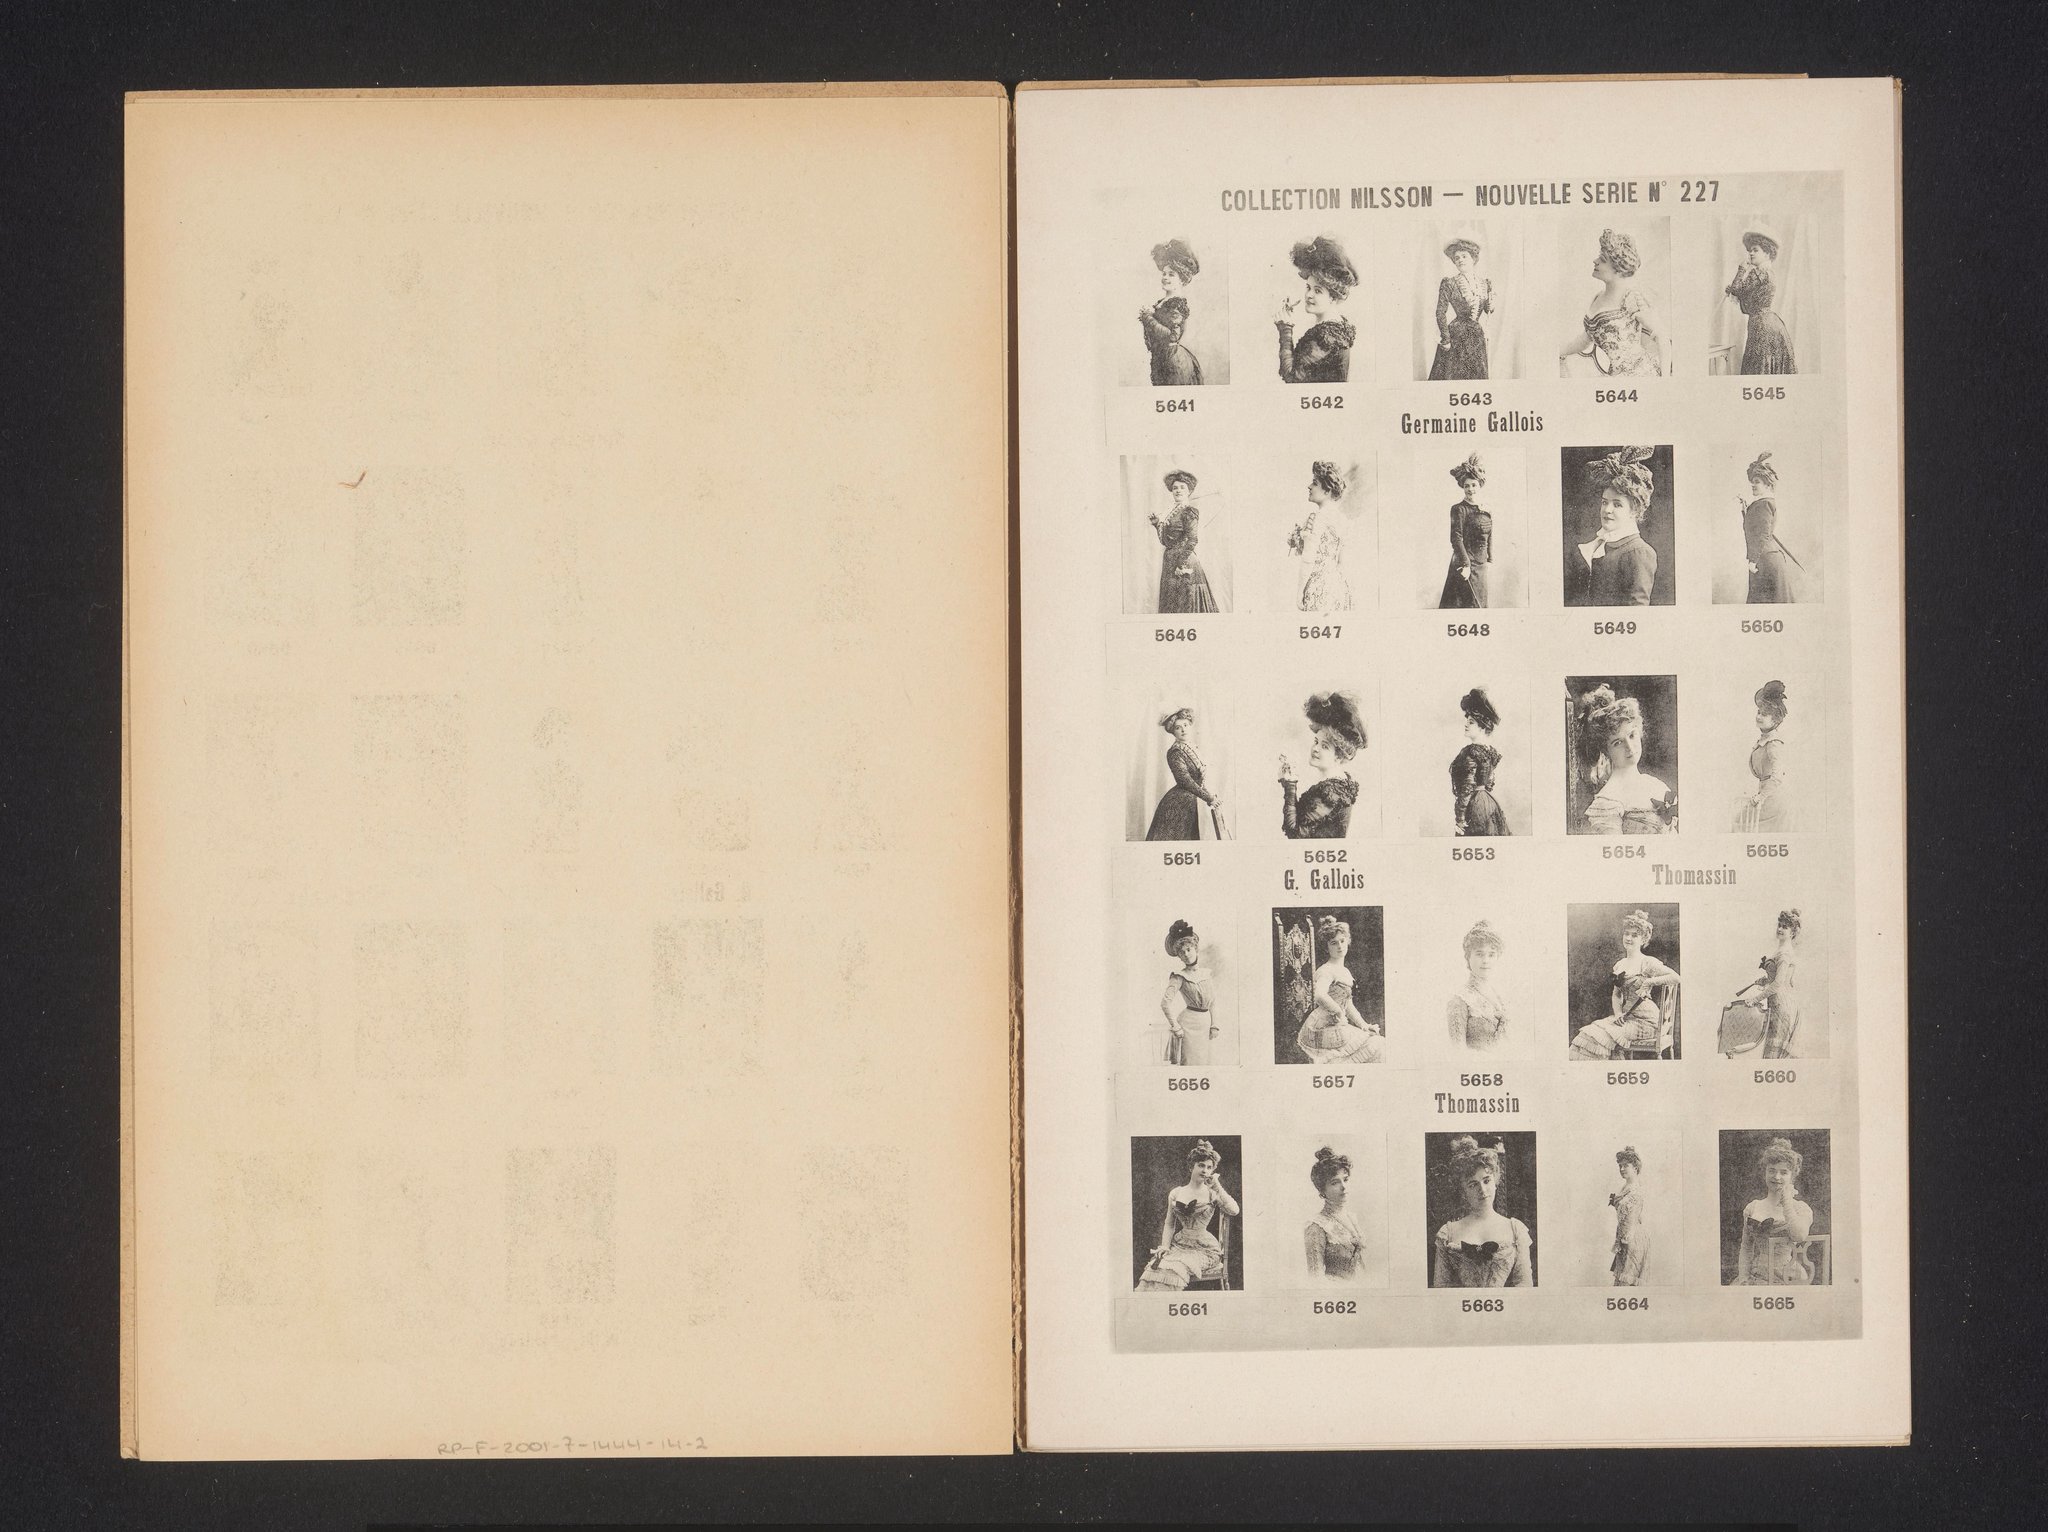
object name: page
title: Collection Nilsson - Nouvelle Série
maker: Anonymous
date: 1894-1899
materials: paper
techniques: photograph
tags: historical persons - bb - woman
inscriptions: number: ‘No 227’